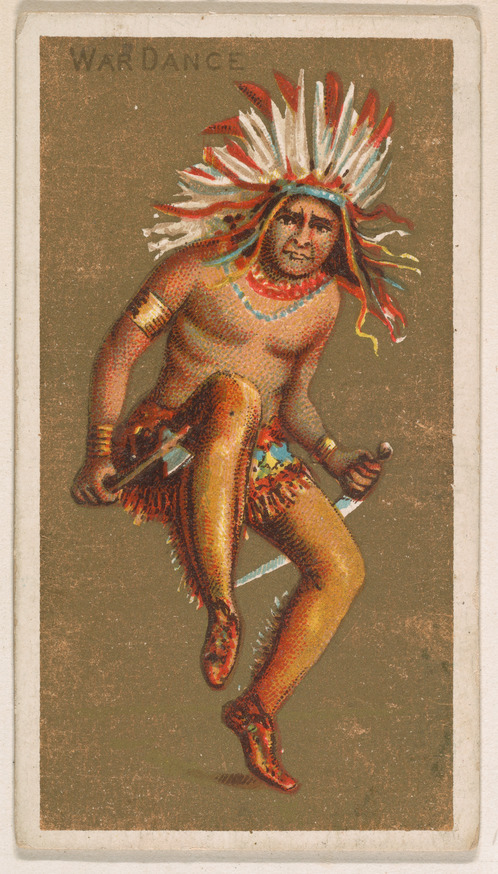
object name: print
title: War Dance, from National Dances (N225, Type 1) issued by Kinney Bros.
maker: kinney brothers tobacco company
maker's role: publisher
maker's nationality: american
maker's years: 1869-2011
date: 1889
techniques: color lithograph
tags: dance,men,dancing